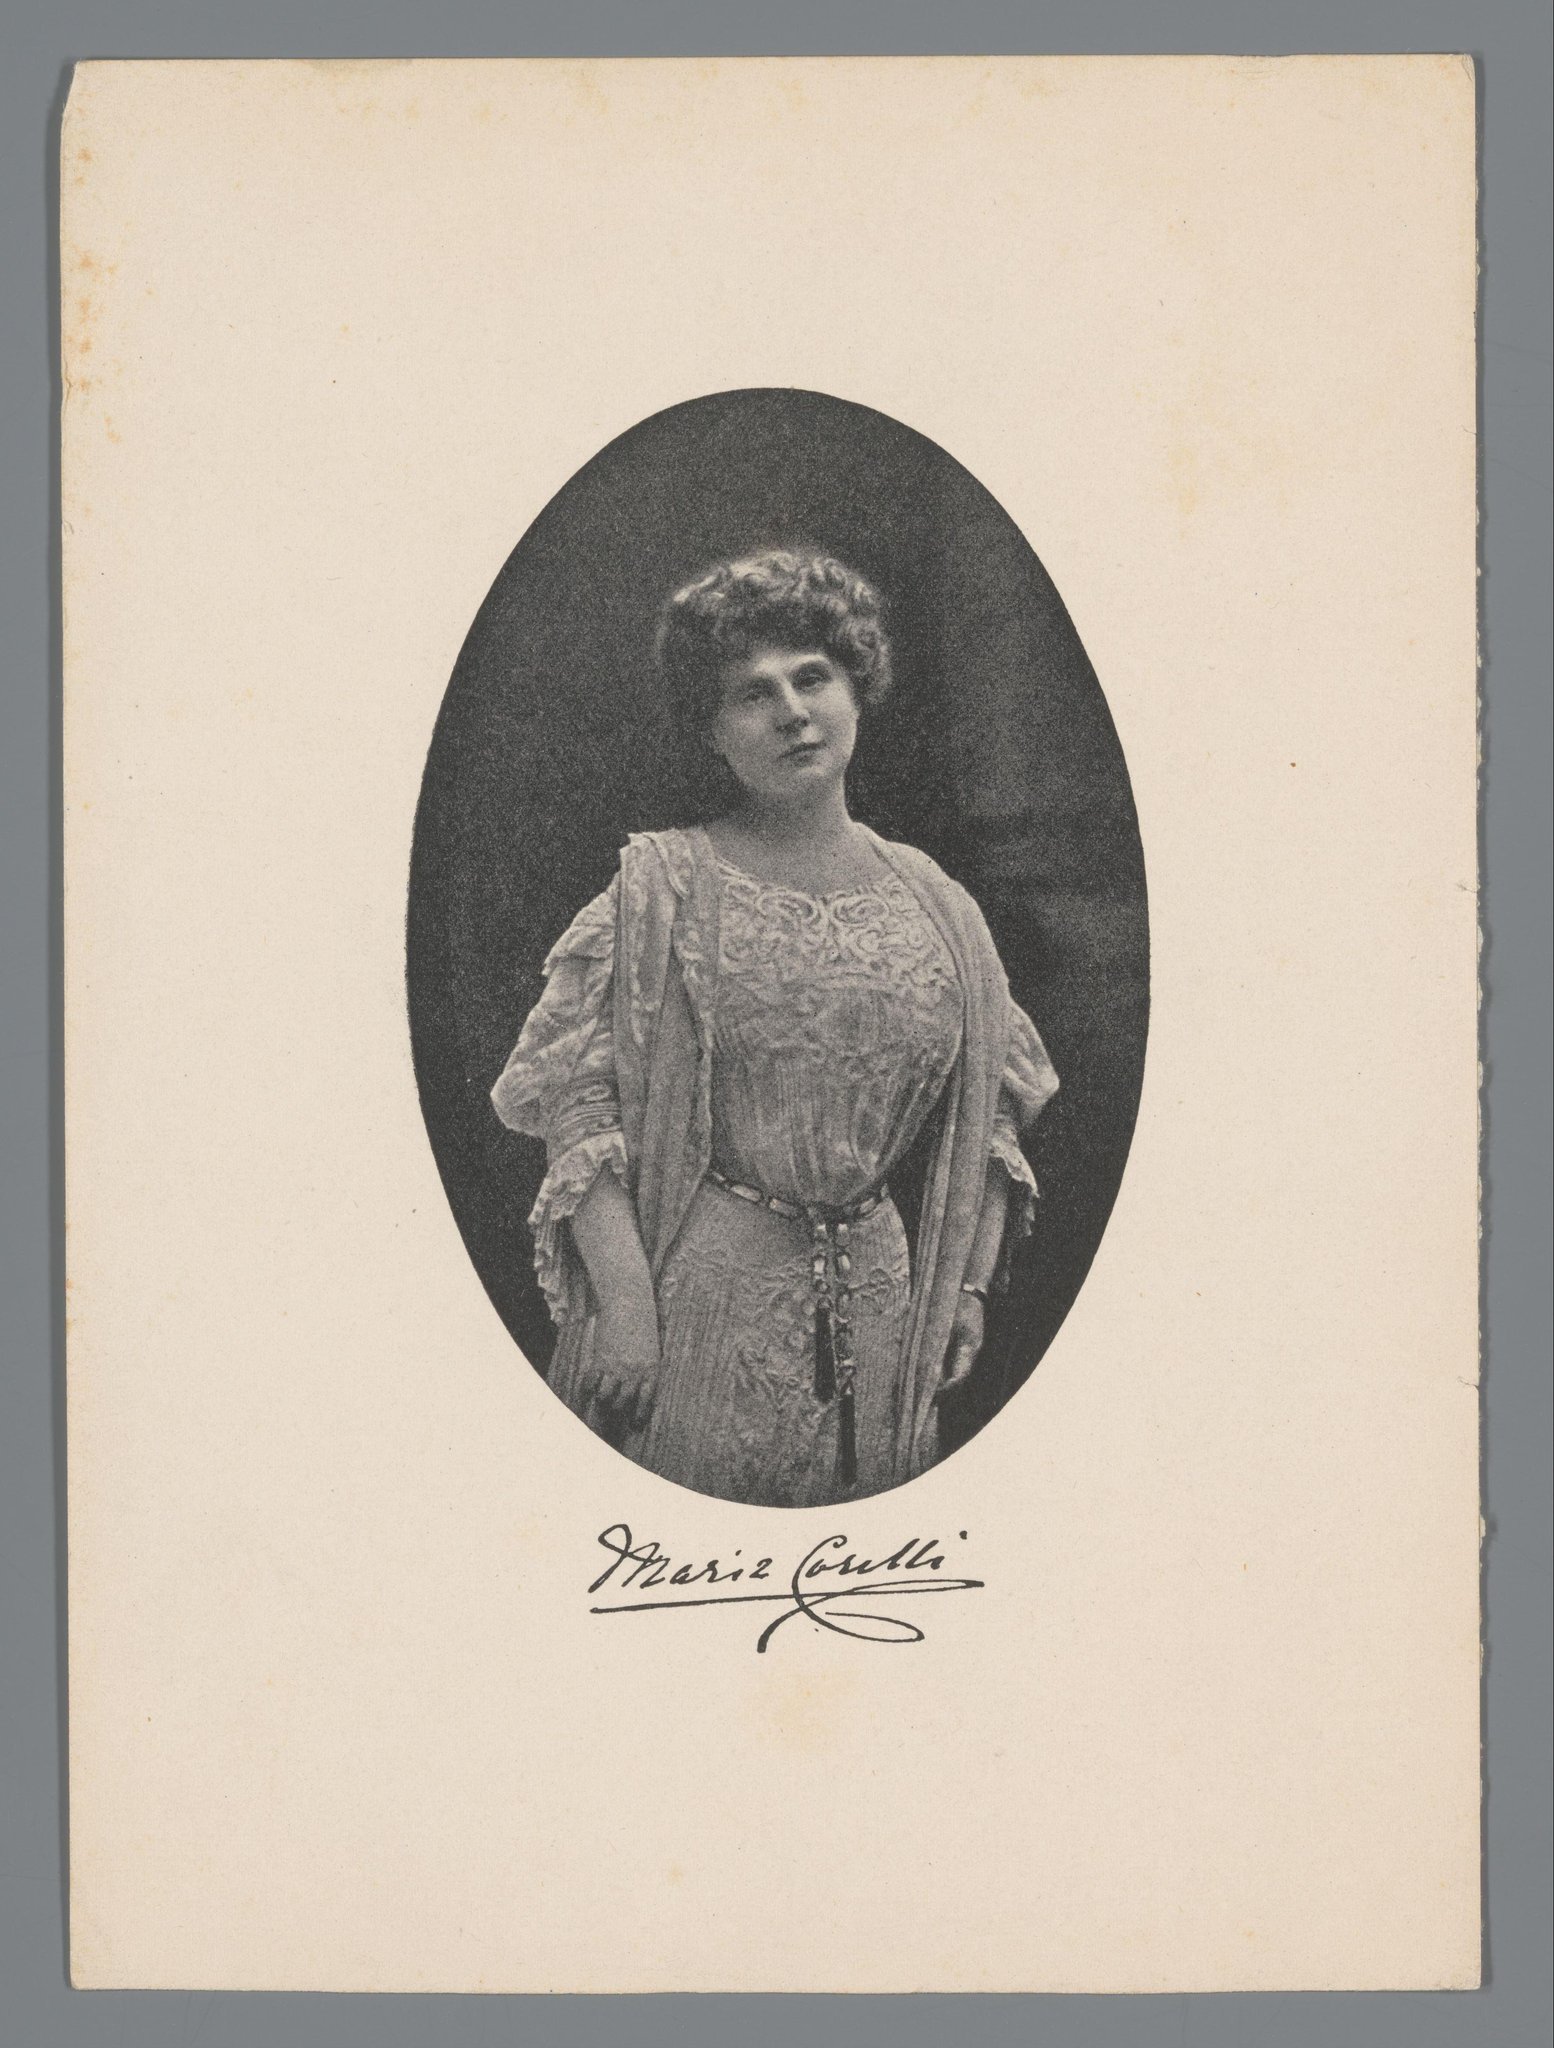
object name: photomechanical print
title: Portret van Marie Corelli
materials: paper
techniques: autotype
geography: london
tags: portrait of a writer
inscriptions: name: ‘Marie Corelli’